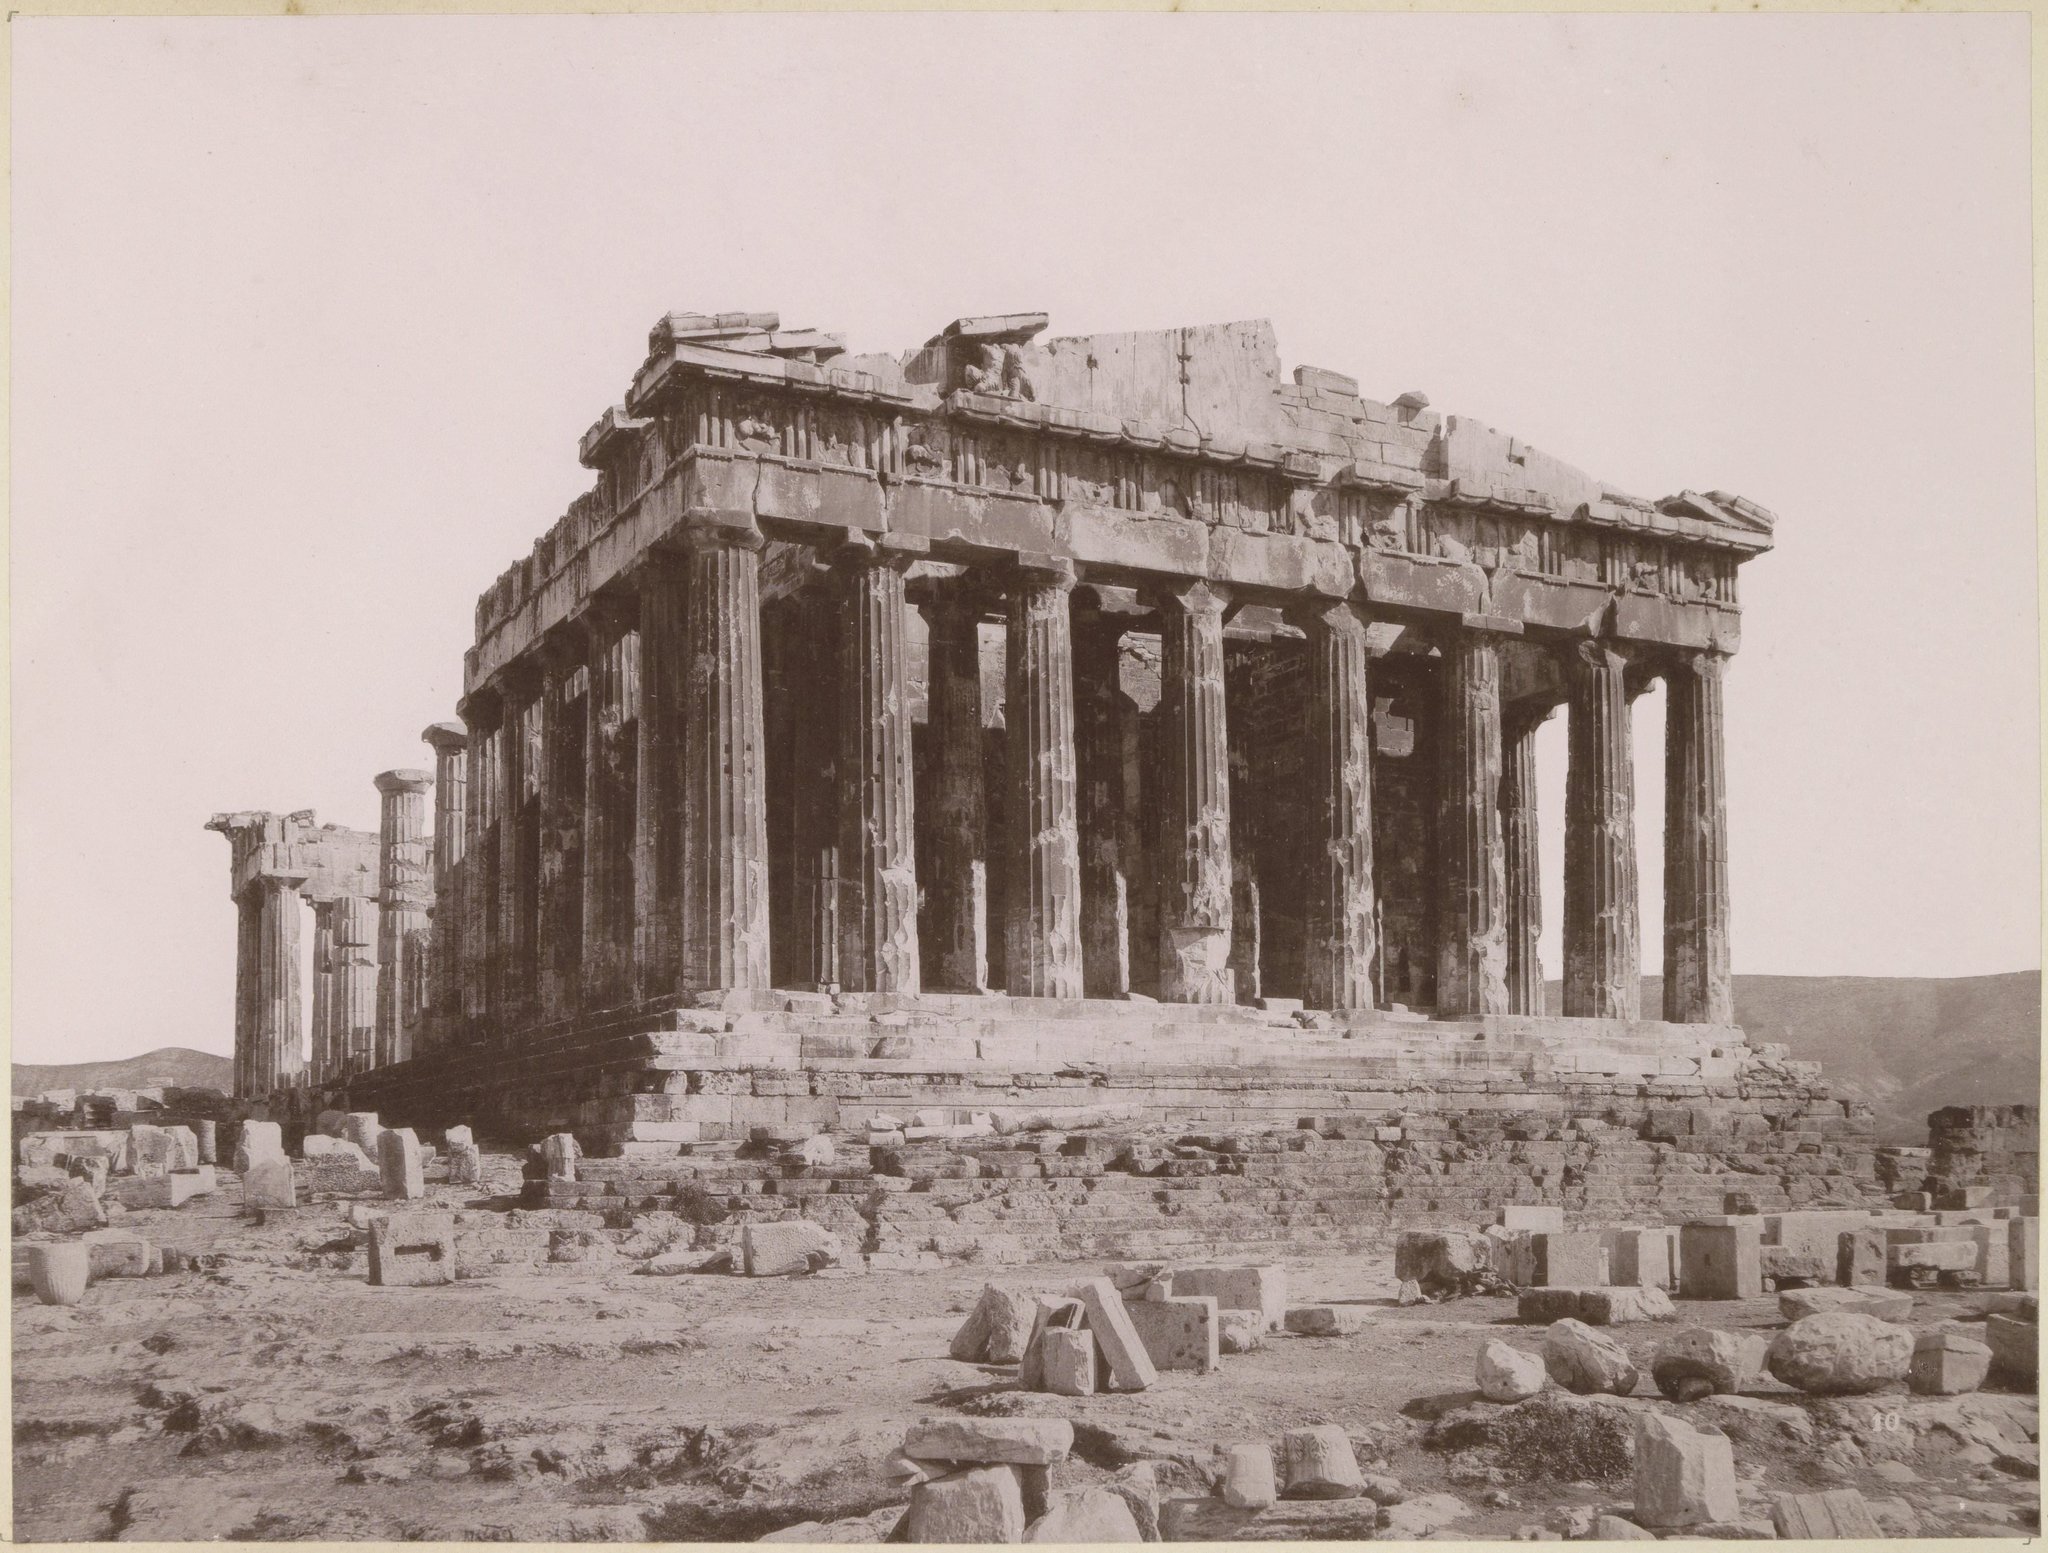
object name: photograph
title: Parthenon op de Akropolis in Athene (westzijde)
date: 1880-1890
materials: paper, photographic support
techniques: photograph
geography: acropolis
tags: column, pillar ~ architecture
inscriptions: negative number: ‘10’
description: Onderdeel van Reisalbum met foto's van bezienswaardigheden in Frankrijk, Griekenland en Turkije.